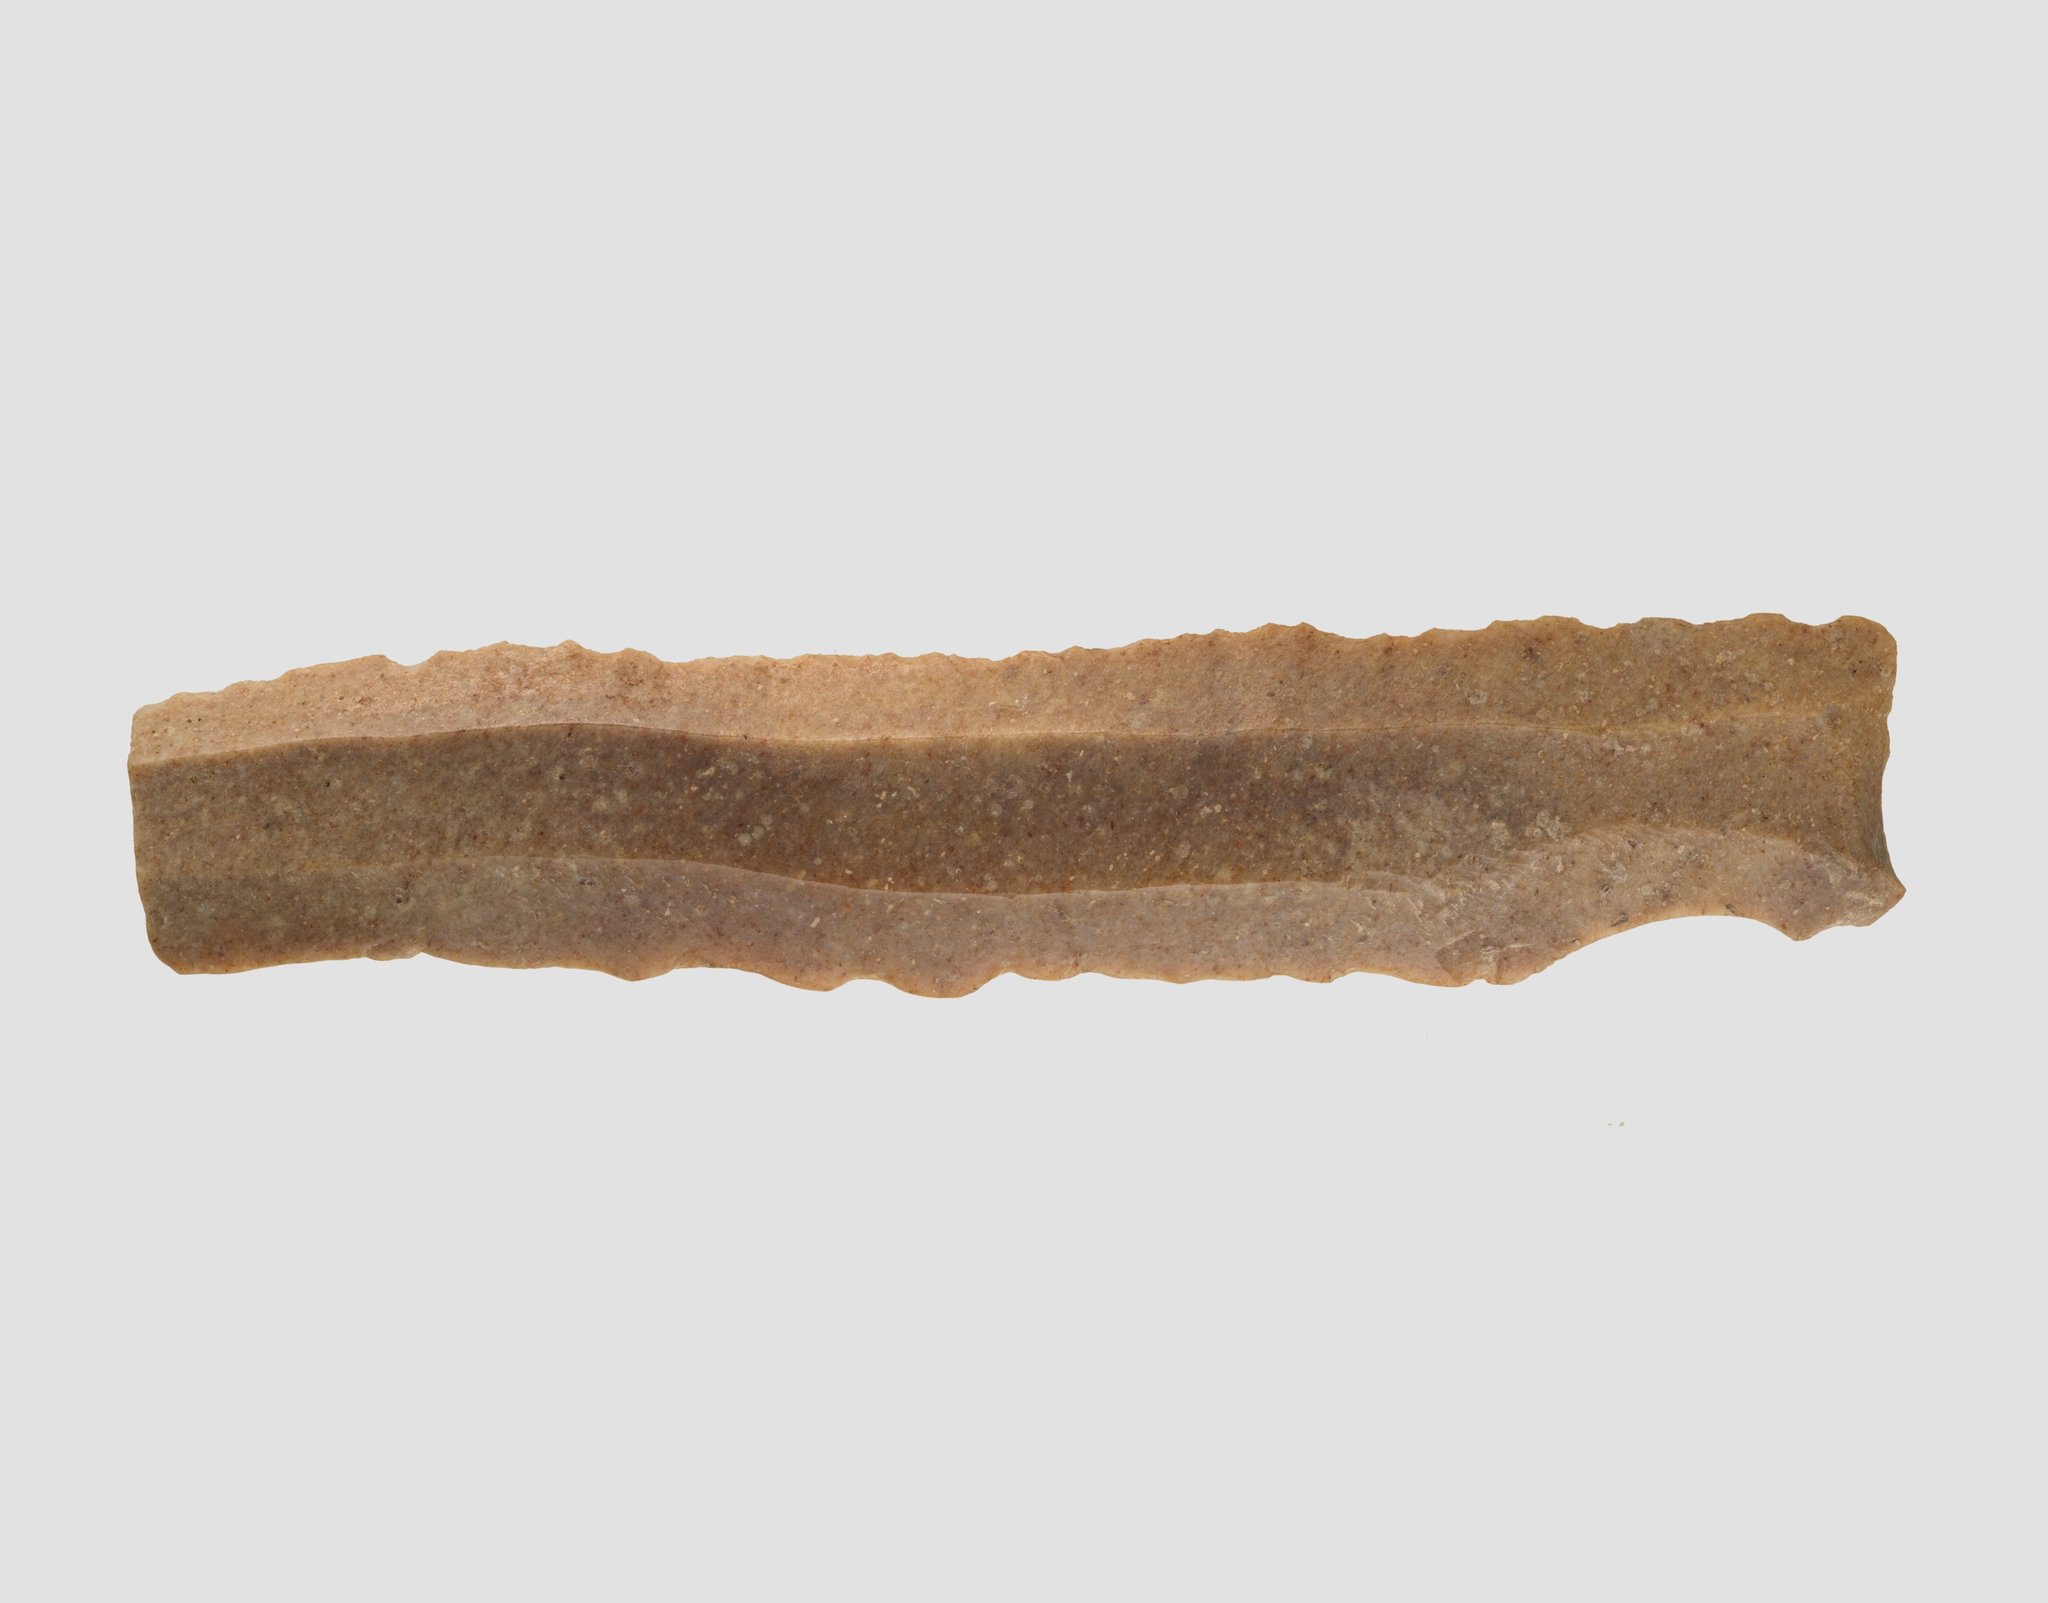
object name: knife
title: Blade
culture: iranian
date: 3100 BCE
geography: iran